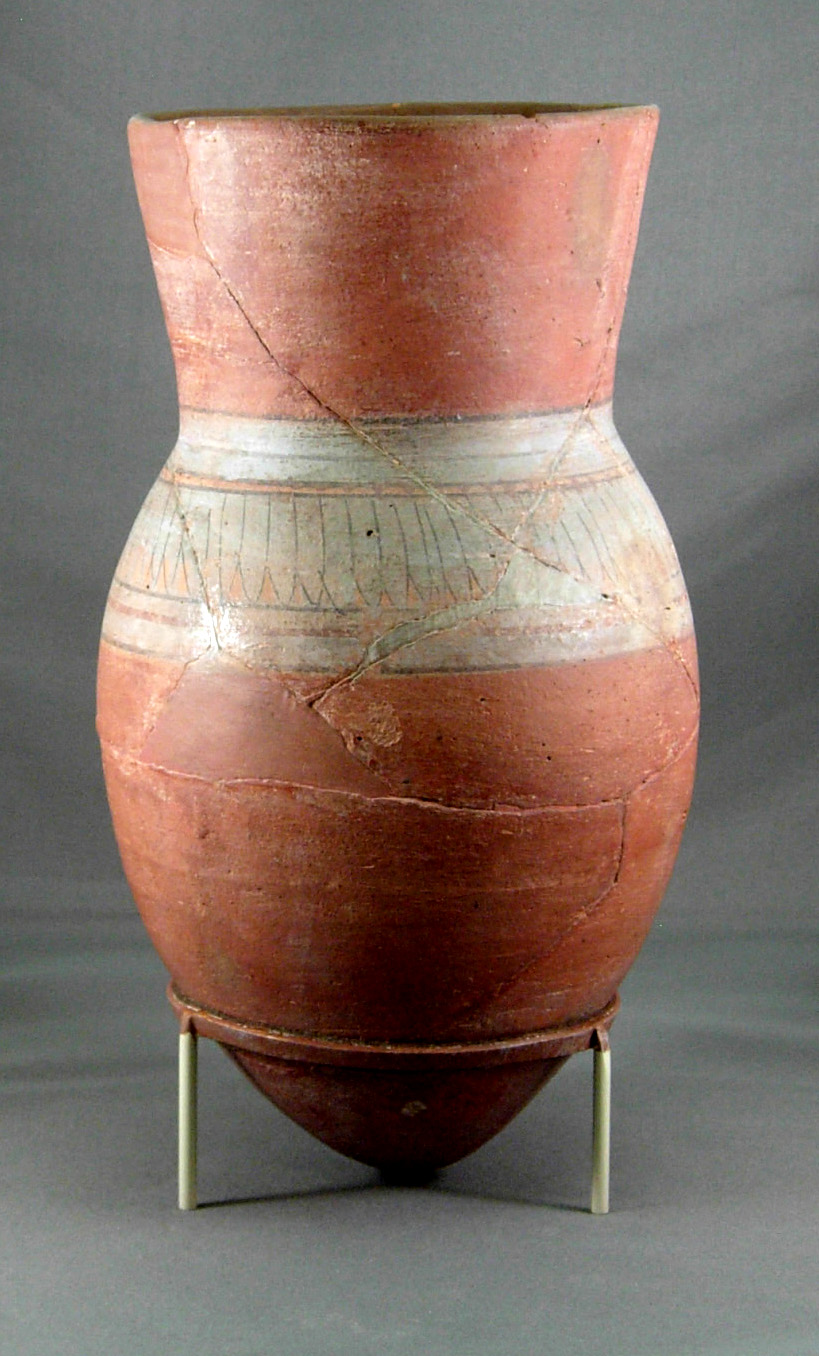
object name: jar, painted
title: Painted Jar from Tutankhamun's Embalming Cache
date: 1336-1327 BCE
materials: pigment, pottery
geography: egypt